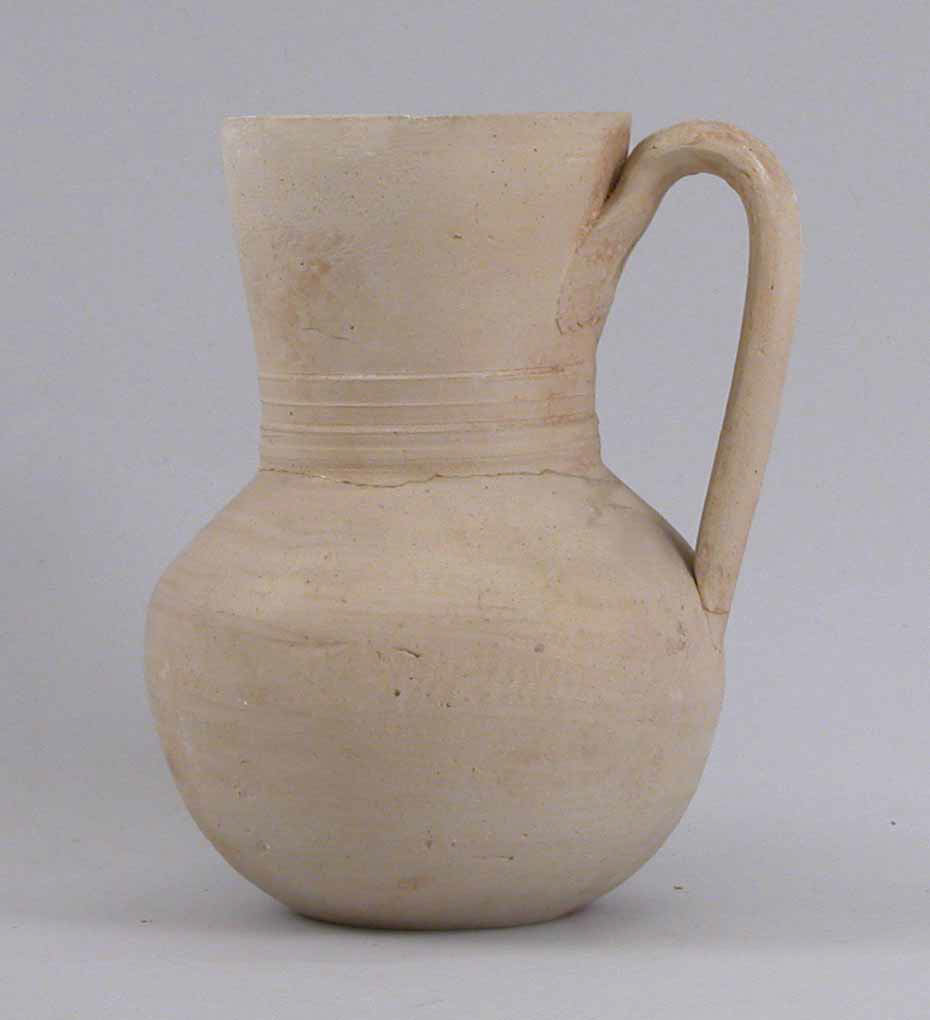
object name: ewer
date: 767-833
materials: earthenware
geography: iran